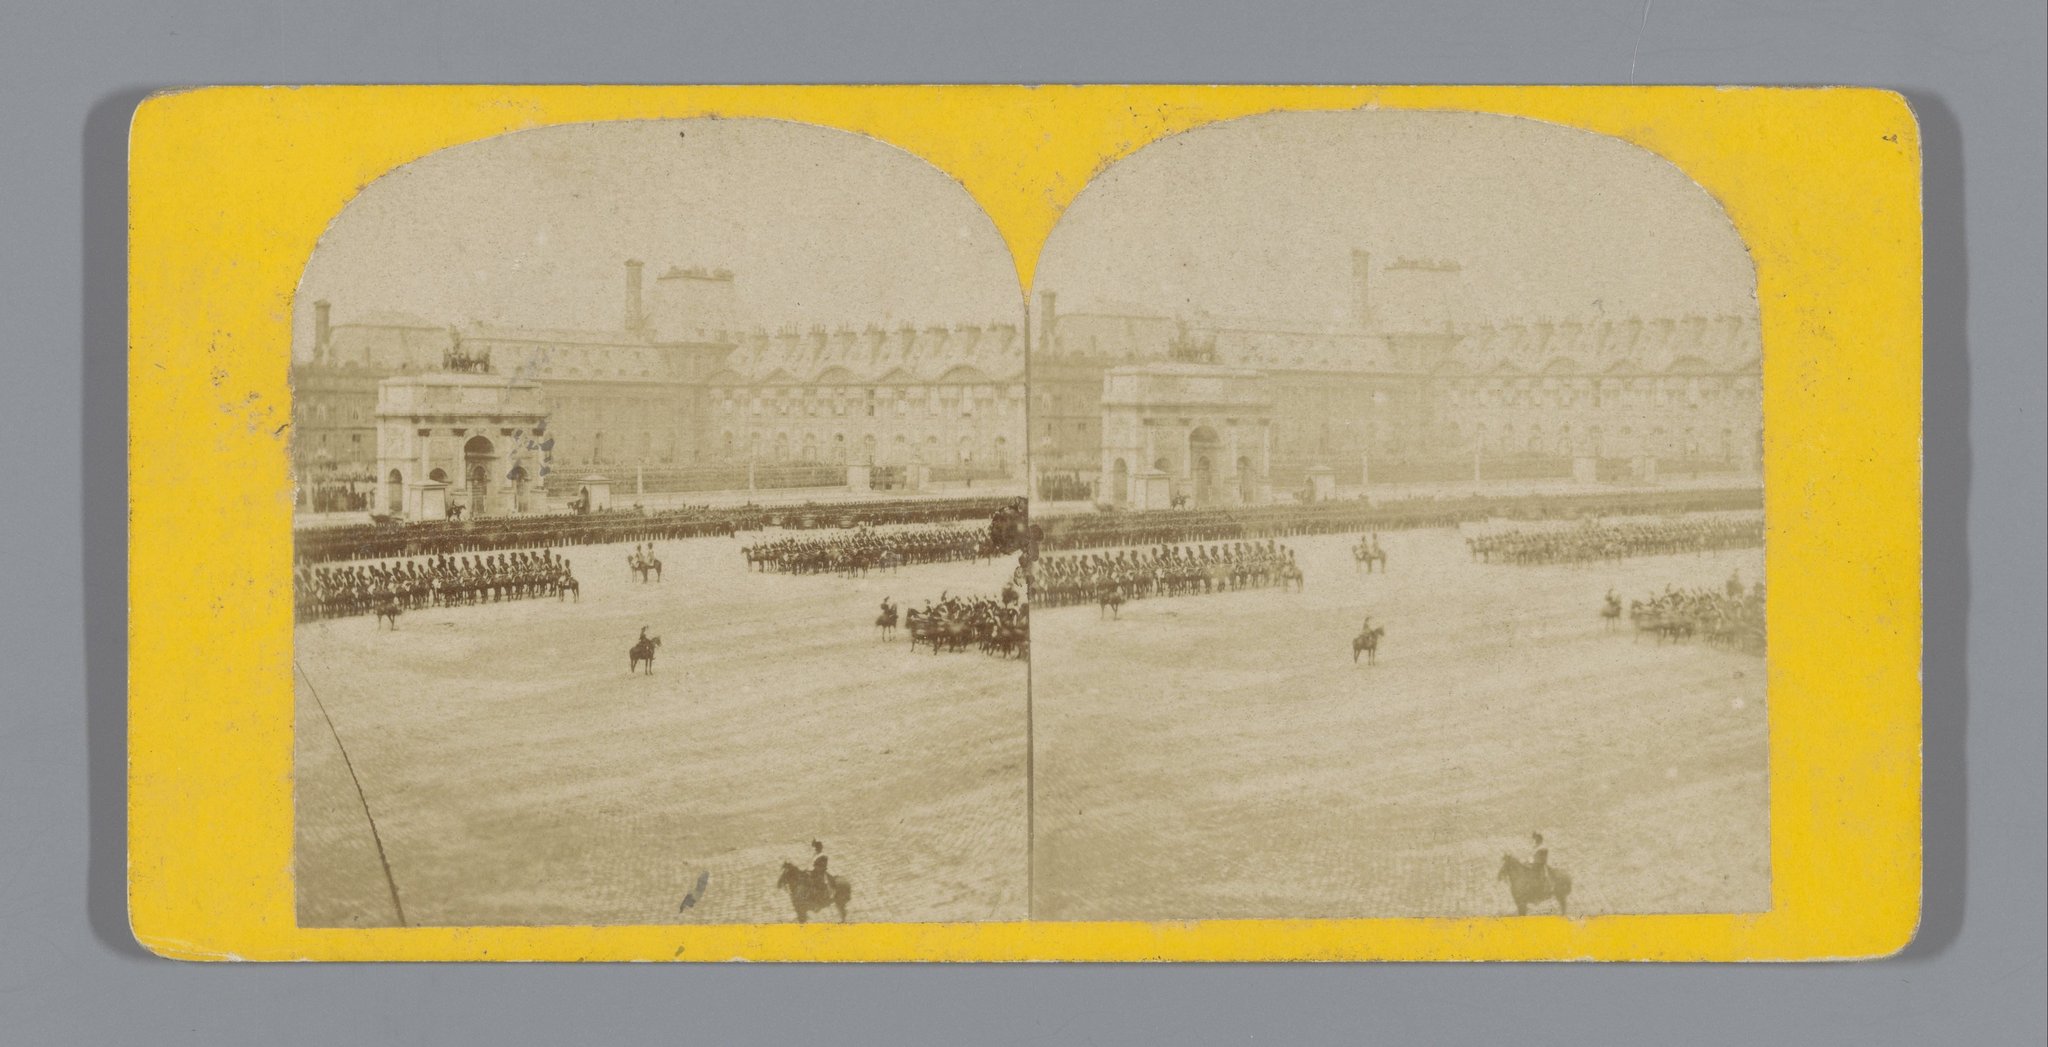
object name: stereograph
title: Opstelling van cavaleristen op het Place du Carrousel te Parijs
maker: Anonymous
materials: cardboard, photographic support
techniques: albumen print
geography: place du carrousel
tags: riding a horse, ass, or mule; rider, horseman, square, place, circus, etc., triumphal arch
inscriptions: inscription: ‘Place du Carousel le louvre’